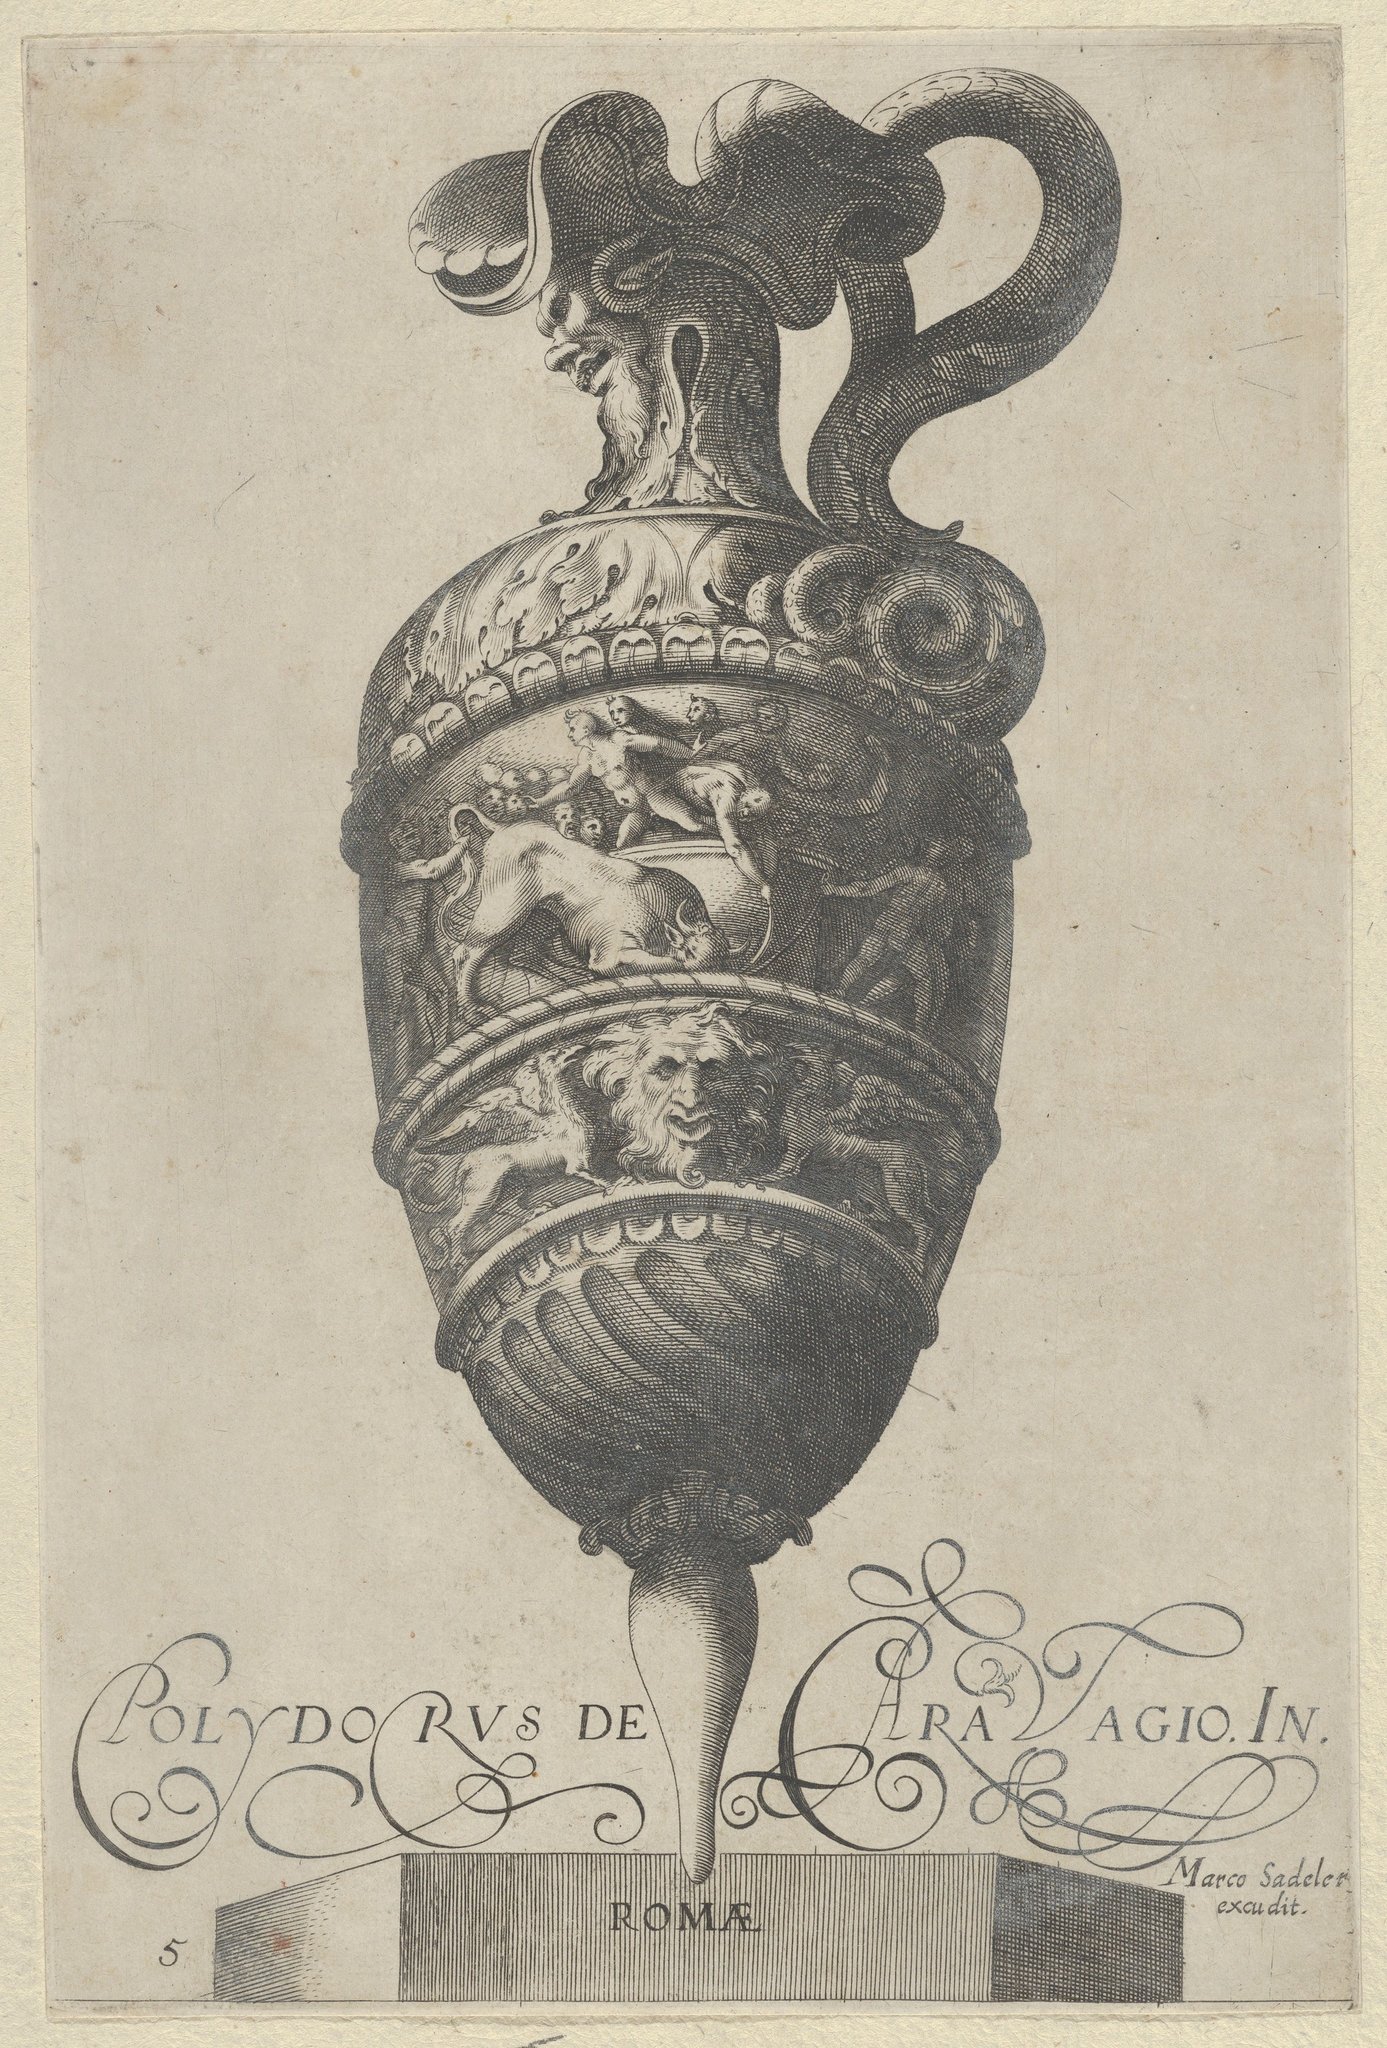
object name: print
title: Plate 5: Vase or Ewer with a Double Frieze, the Top shows Men Wrestling a Bull, the Bottom contains a Mask and Two Griffins, from "Antique Vases" (Vasa a Polydoro Caravagino)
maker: aegidius sadeler (ii)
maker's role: artist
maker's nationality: flemish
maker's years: 1568-1629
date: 1605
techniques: engraving, etching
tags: masks,men,griffins,bulls,vases